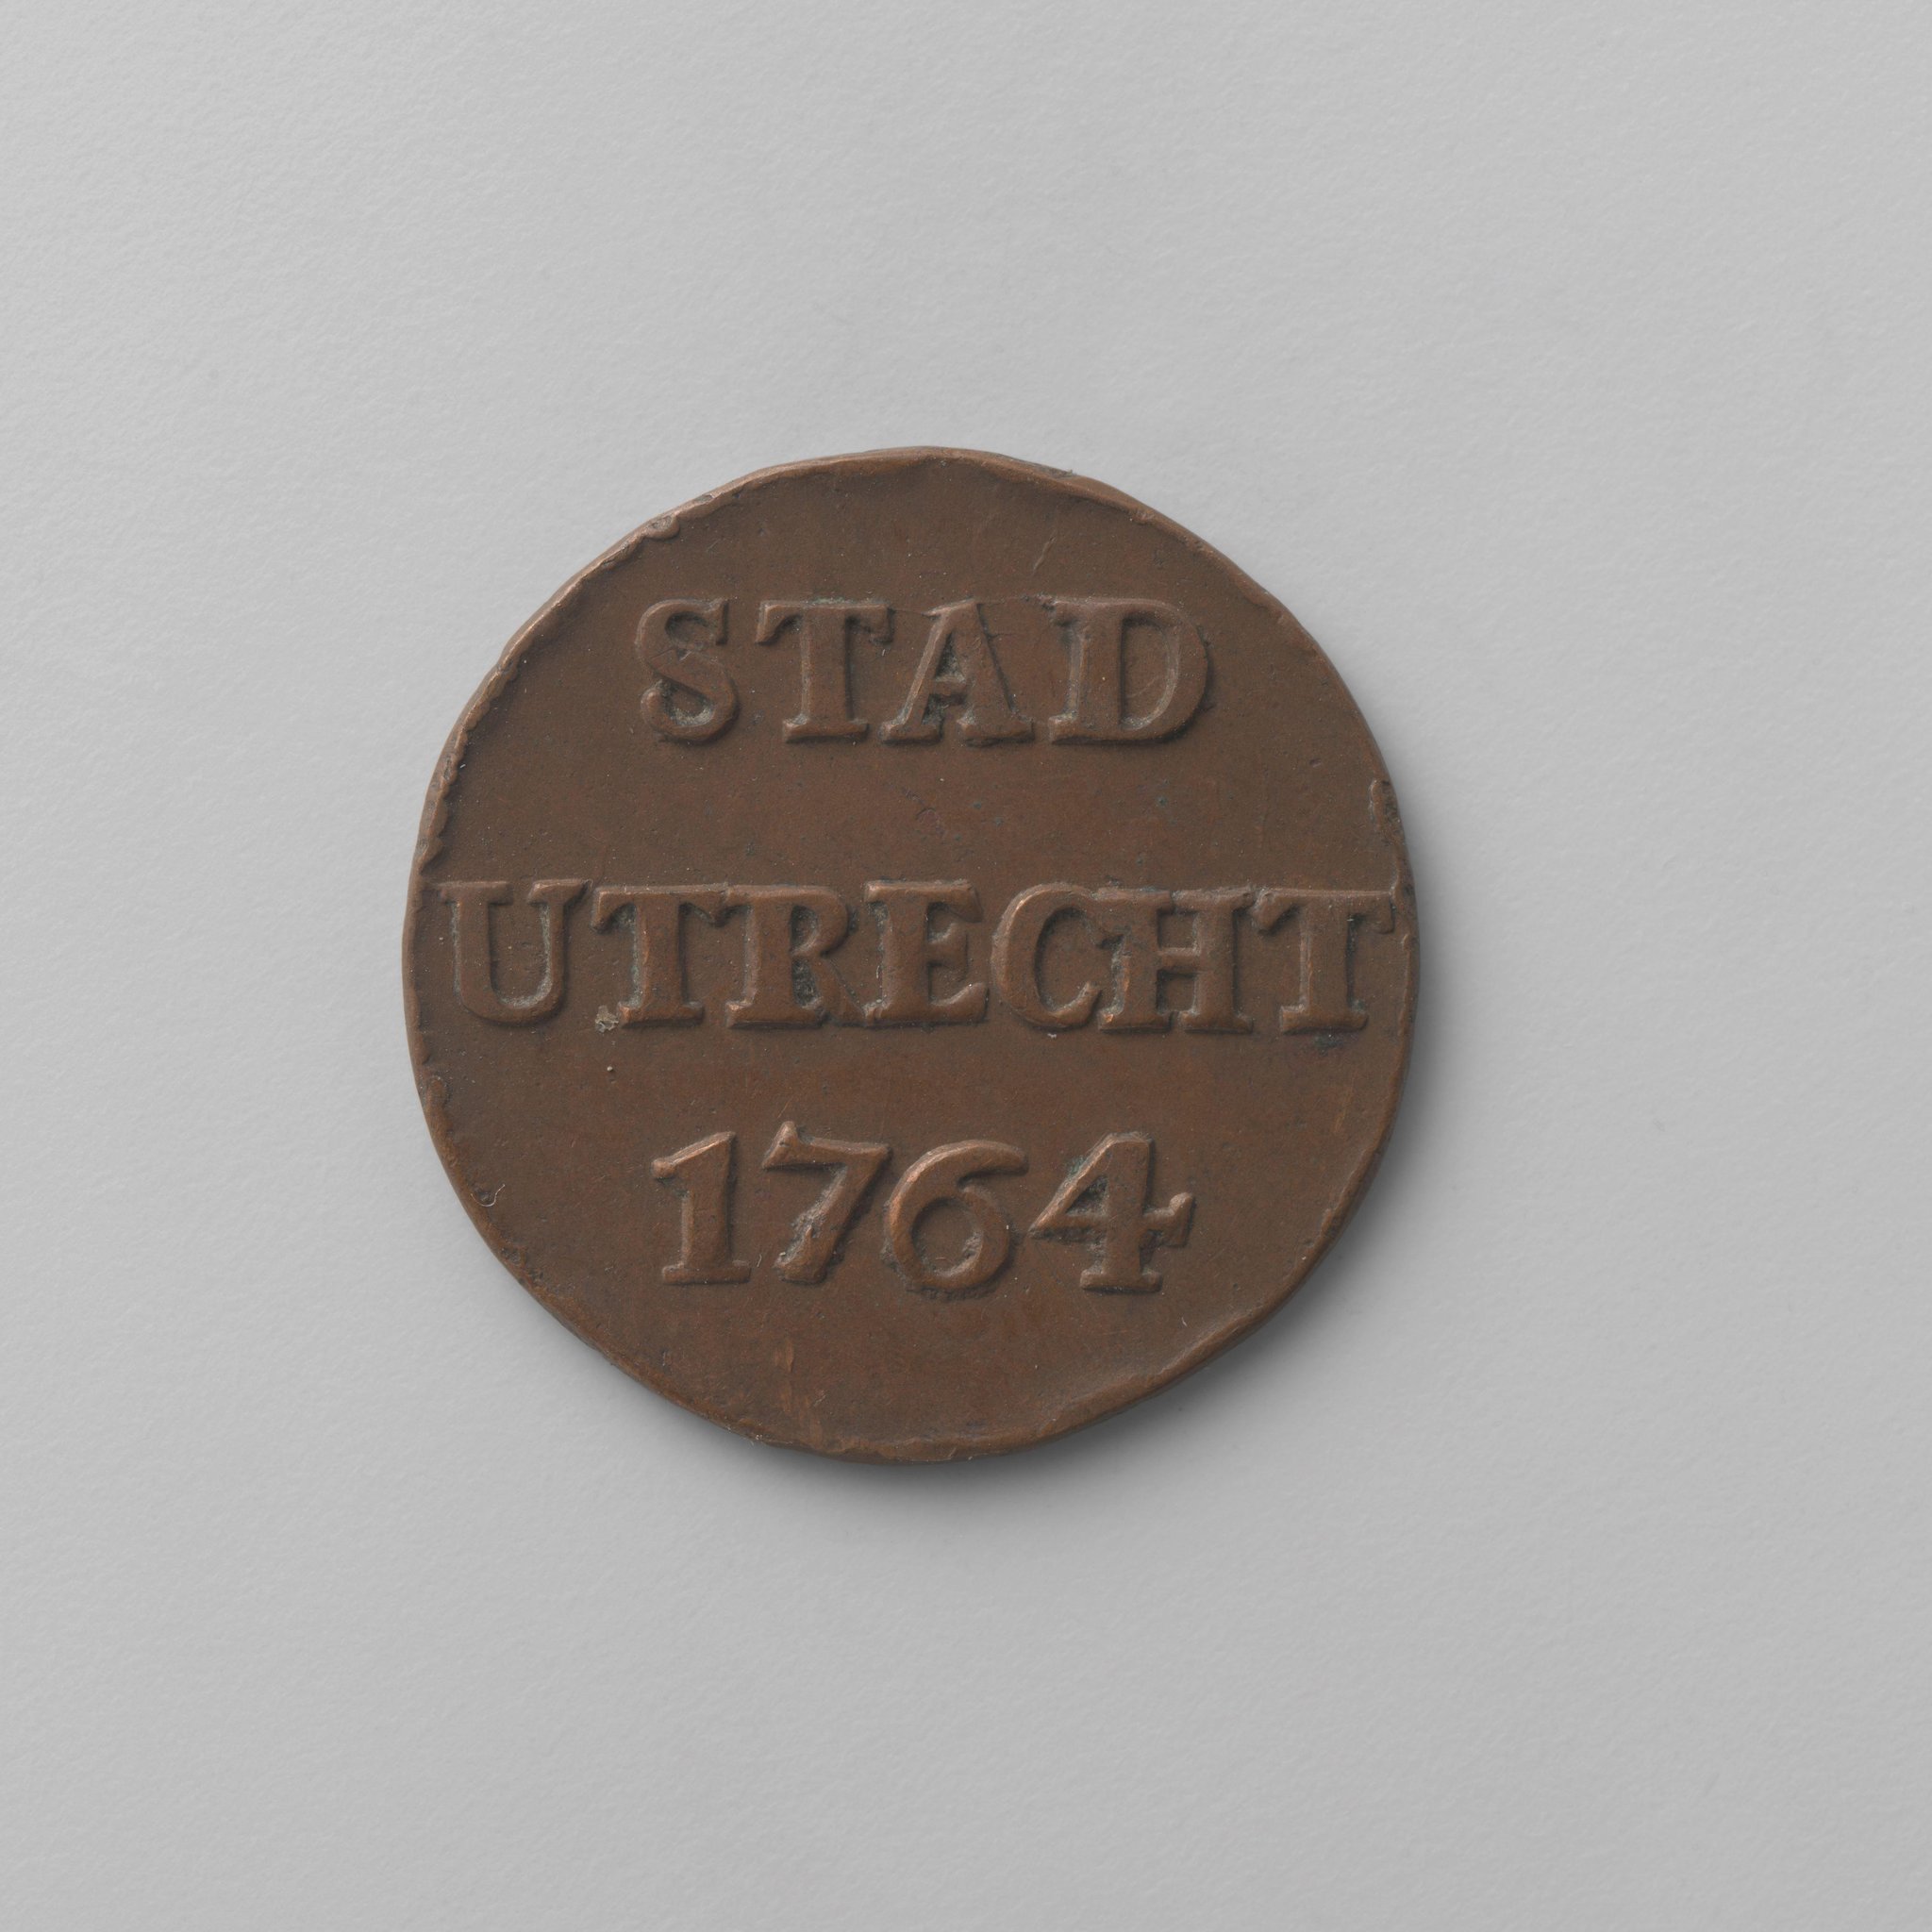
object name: coin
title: Duit van de stad Utrecht, 1764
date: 1764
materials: copper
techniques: striking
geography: utrecht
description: Koperen munt. Voorzijde: gekroond stedelijk wapenschild, gehouden door twee leeuwen met in afsnede dikke lijn, waaronder een versierde accolade met een grote schelp. Keerzijde: opschrift in twee regels, waaronder jaartal. Jaartal met Arabische 1.